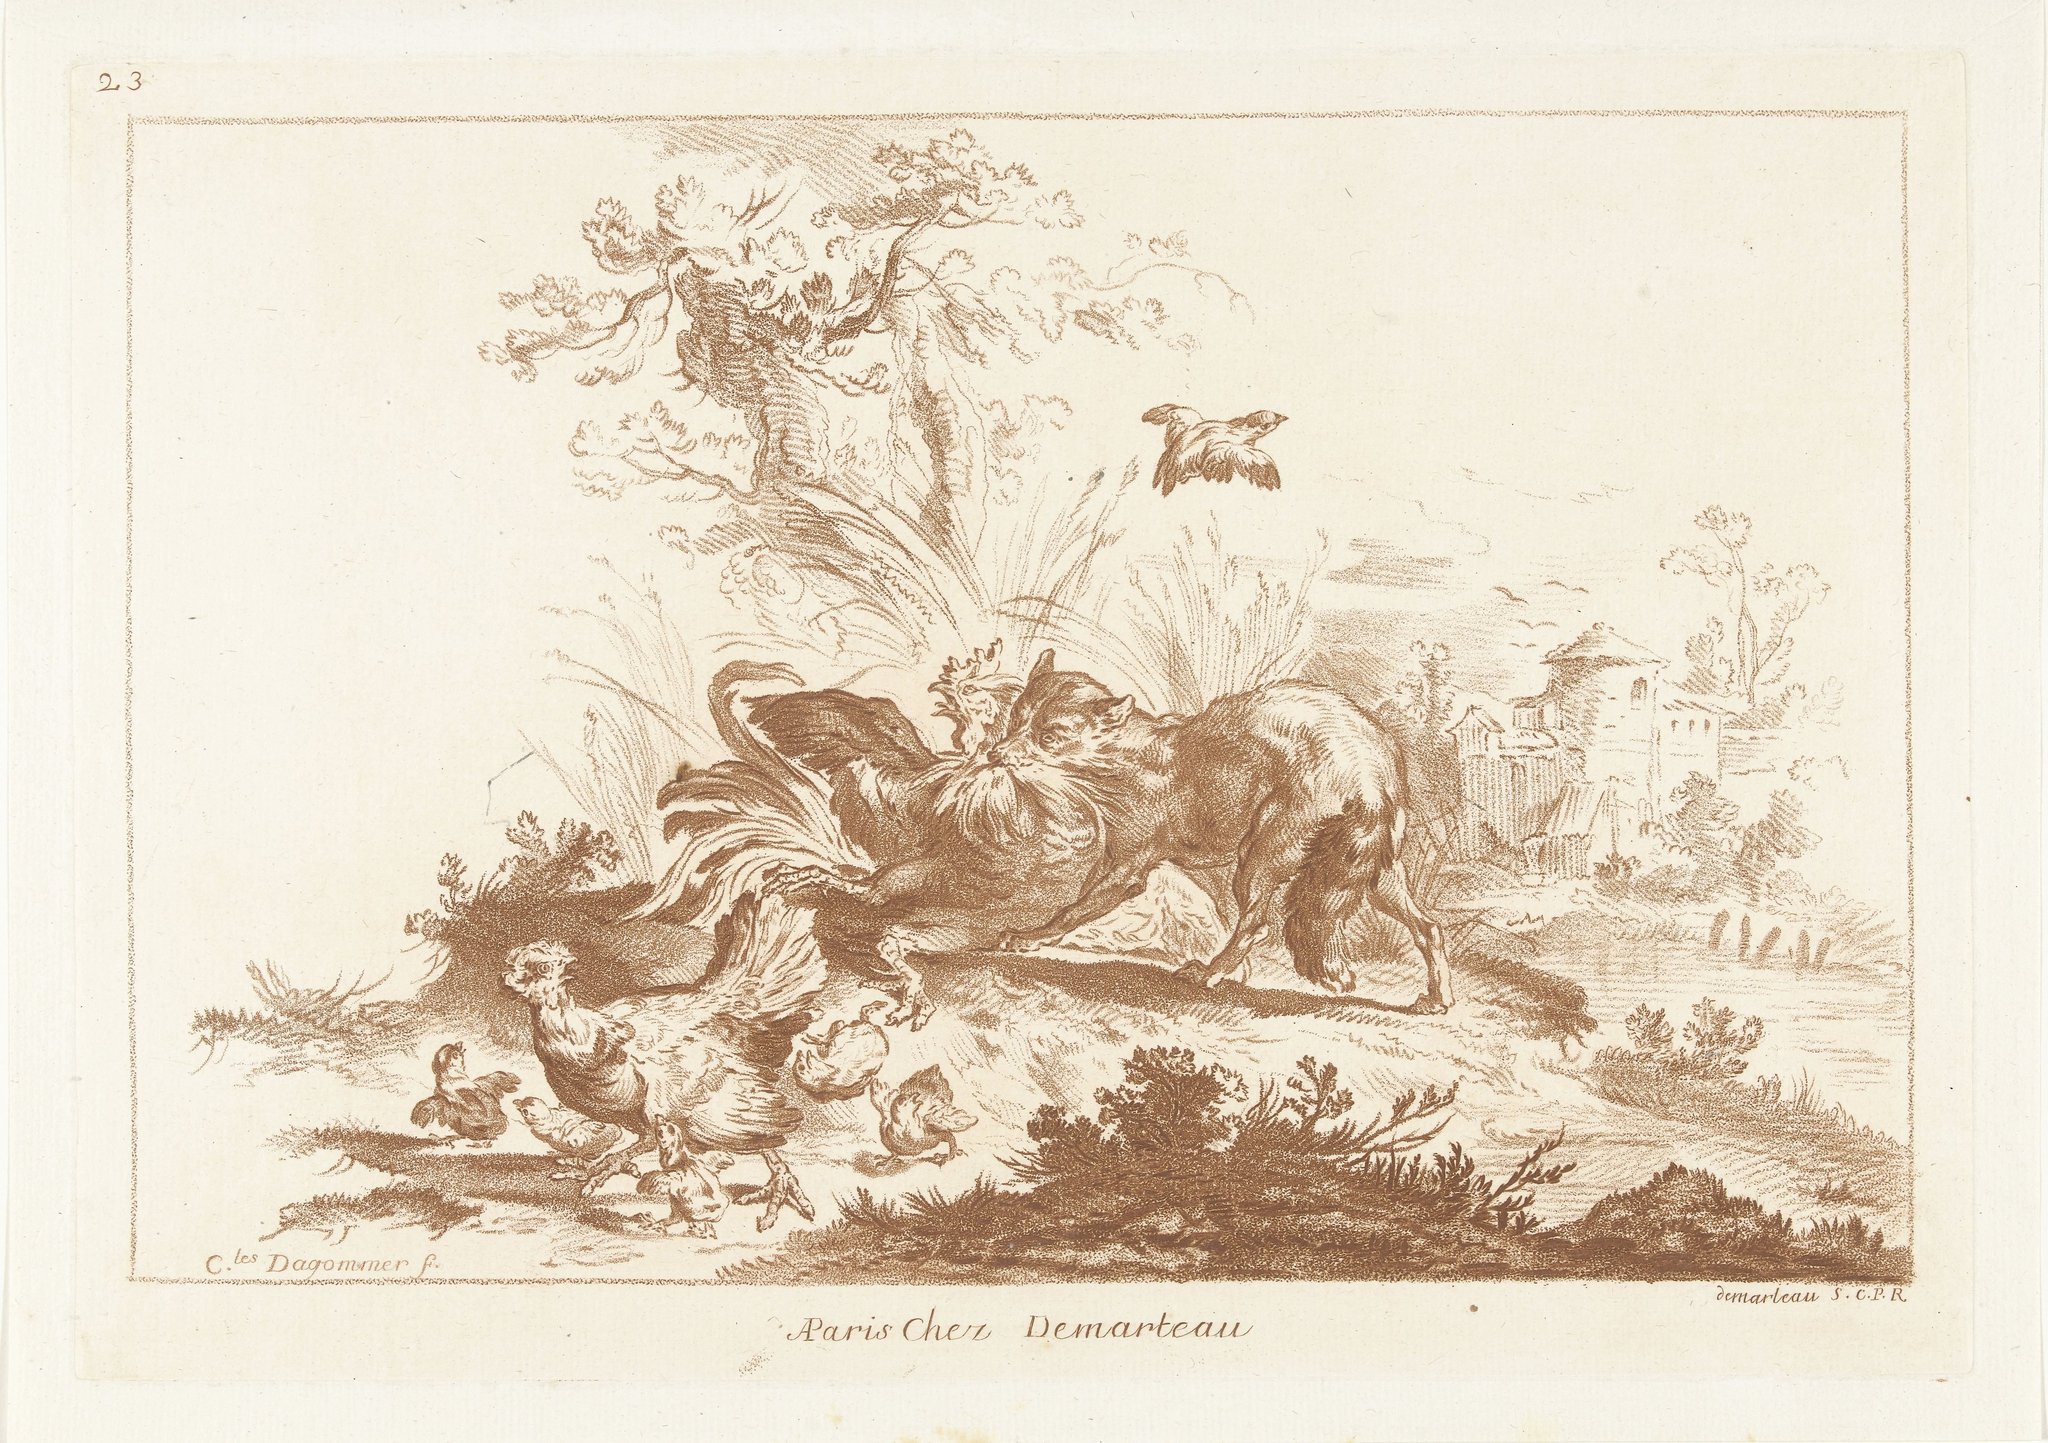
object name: print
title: Vos valt haan aan en hen vlucht met kuikens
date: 1732-1776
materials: paper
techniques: printmaking, etching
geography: paris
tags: fowl (cock, hen, chicken, etc.), beasts of prey, predatory animals: fox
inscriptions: number: ‘23’, collector's mark: Lugt 2228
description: Illustratie bij fabels van Waties, aldus het inventarisboek.